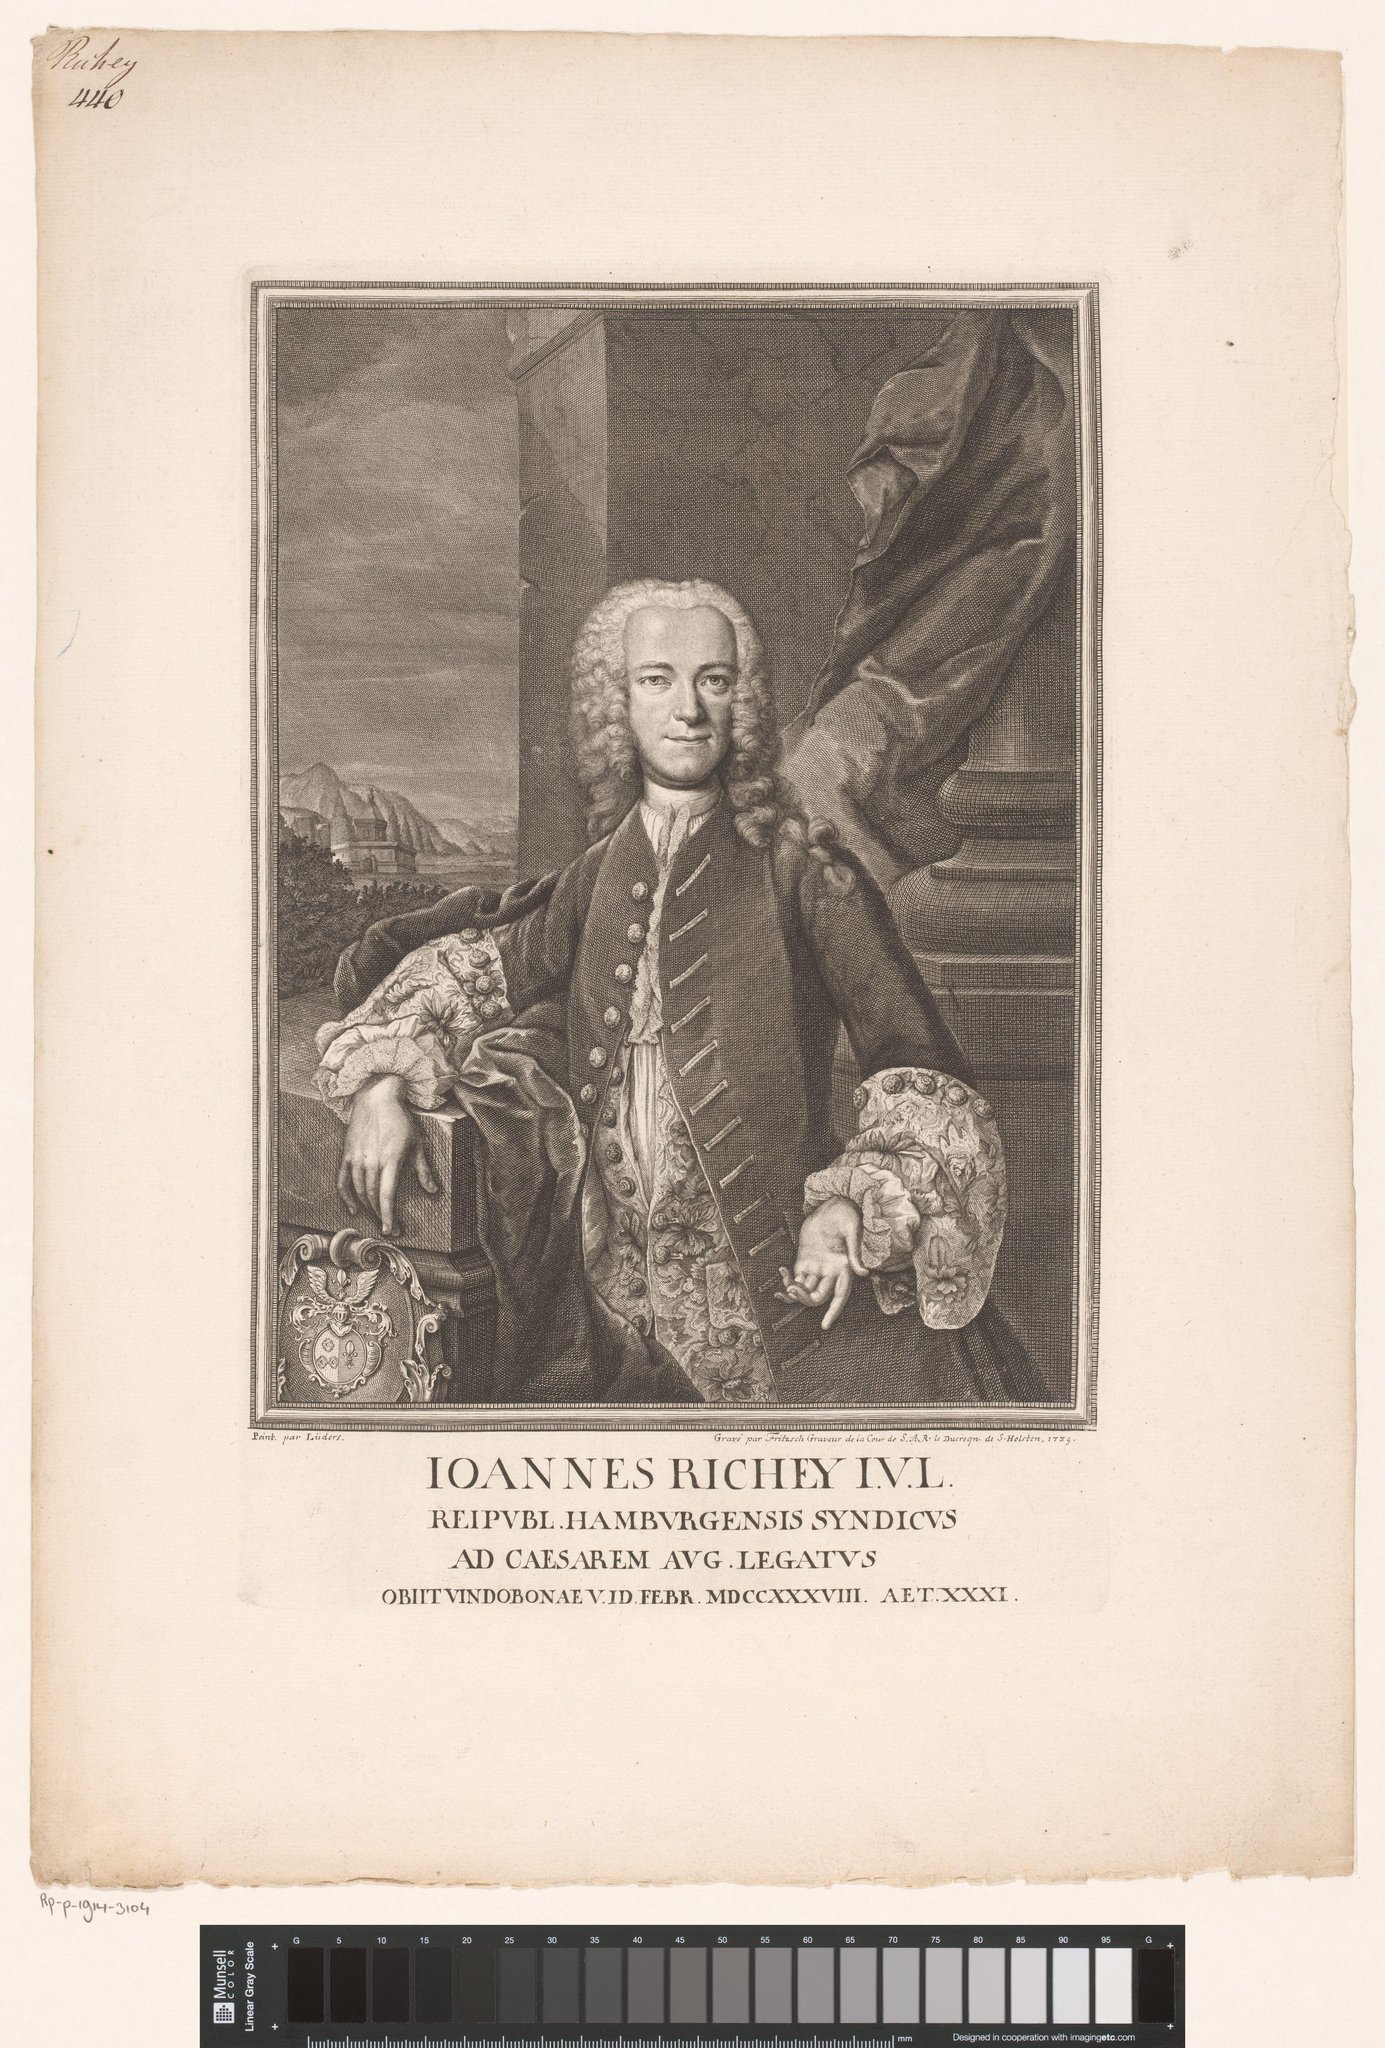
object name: print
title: Portret van Johann Richey op 31-jarige leeftijd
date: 1739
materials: paper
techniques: engraving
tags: city-view in general; 'veduta', historical persons, armorial bearing, heraldry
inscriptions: collector's mark: Lugt 2228